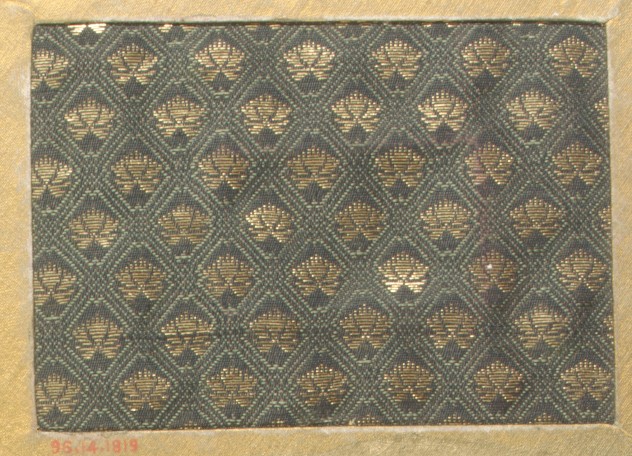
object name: piece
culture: japanese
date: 1701-1900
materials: silk